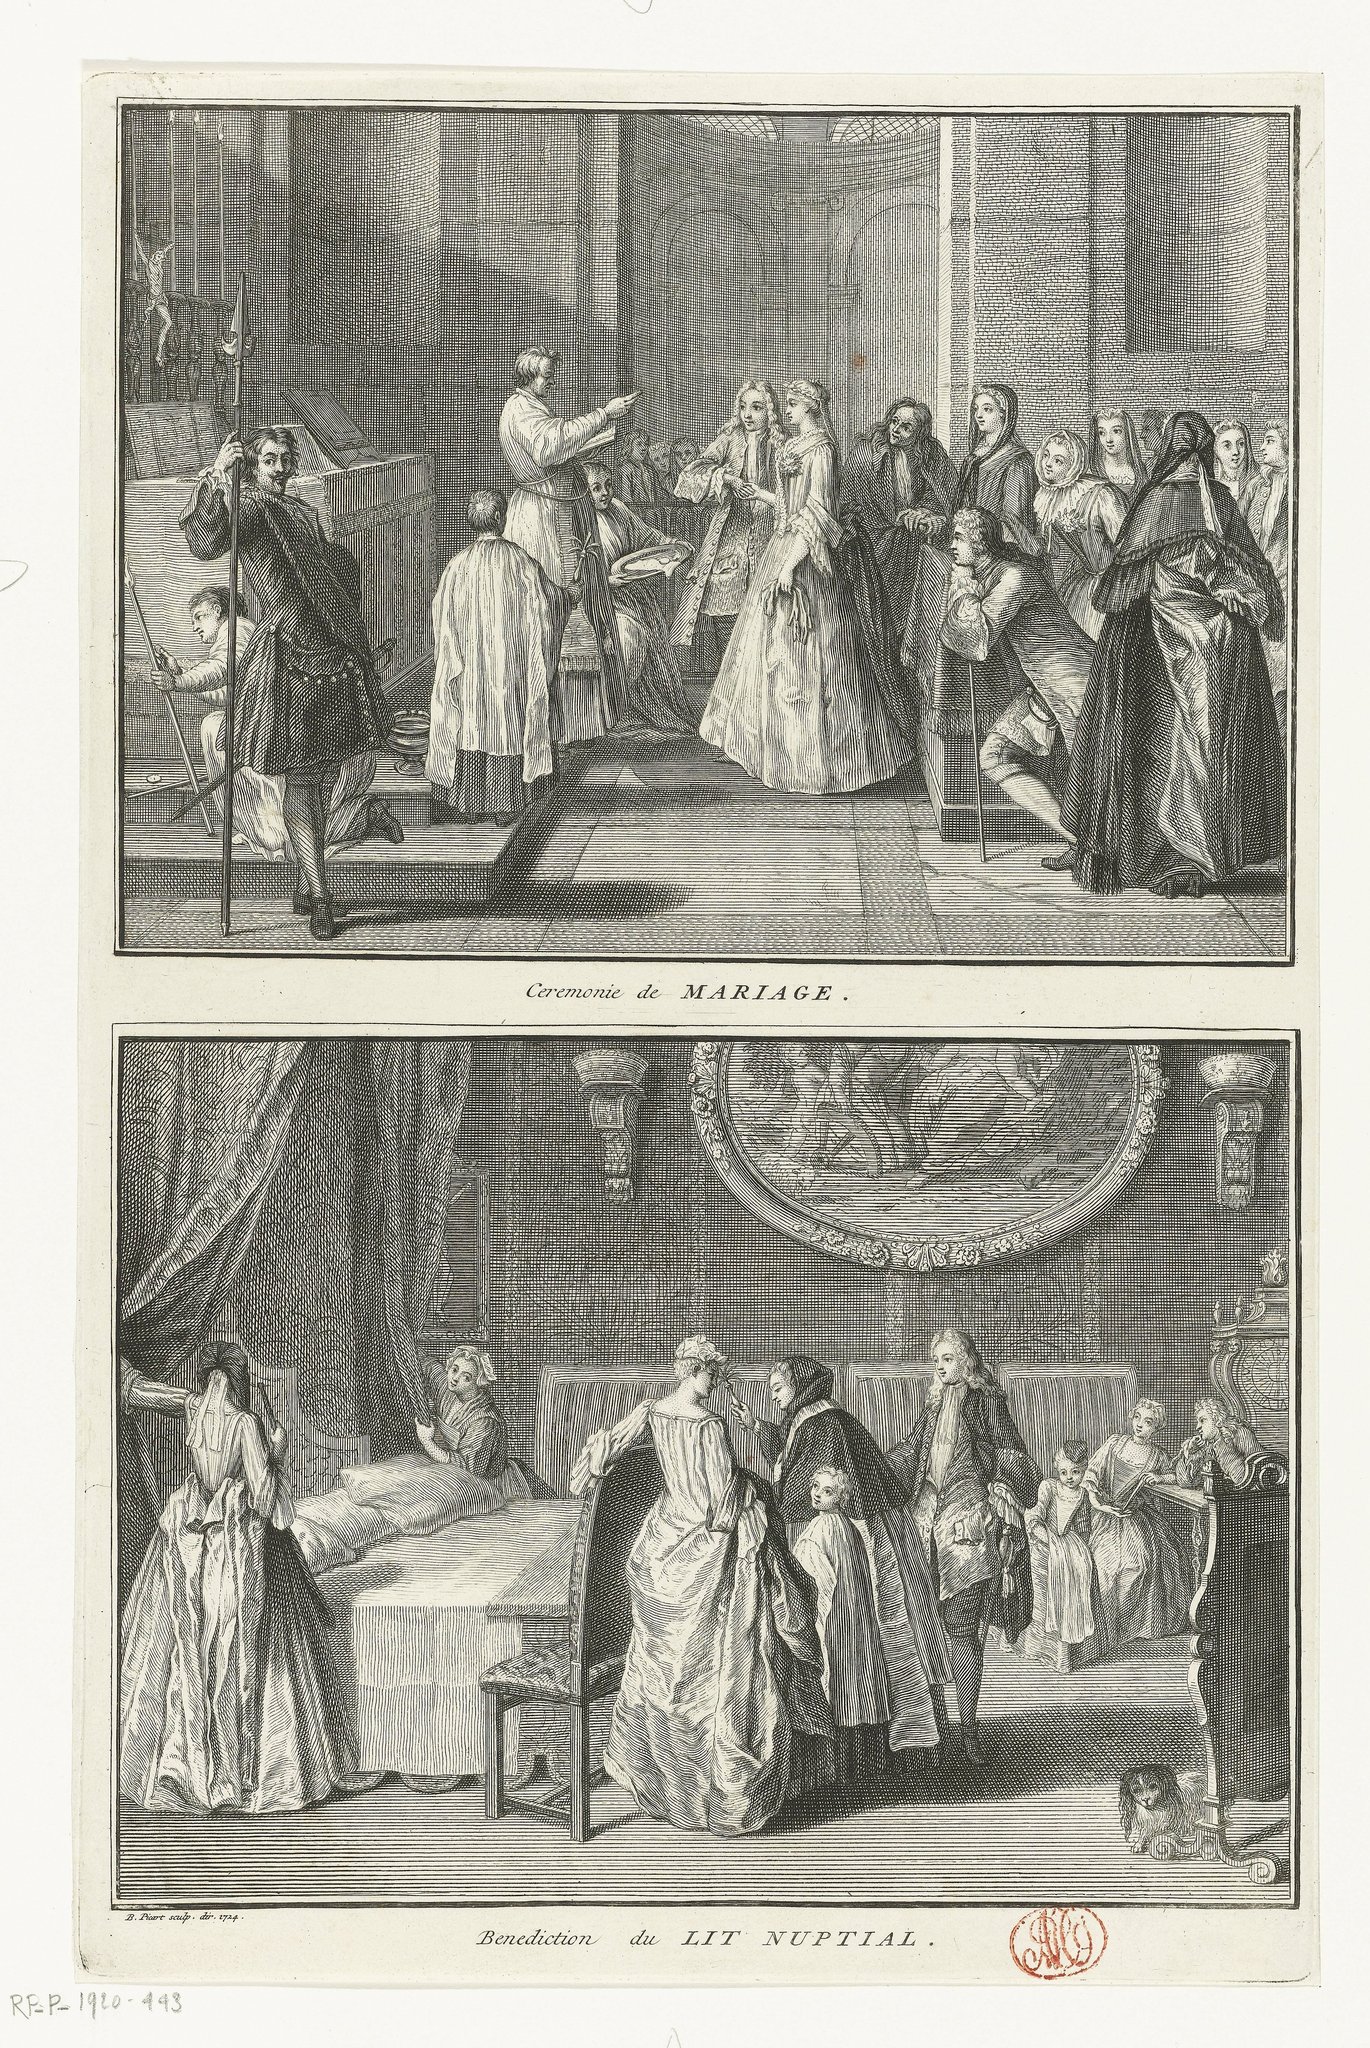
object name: print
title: Rooms-katholieke huwelijksplechtigheid en de zegening van het huwelijksbed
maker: bernard picart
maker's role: draughtsman, print maker, publisher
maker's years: 1673-1733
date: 1724-1727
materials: paper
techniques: engraving, etching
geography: amsterdam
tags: marriage in church ~ the sixth of the seven sacraments, clothes, costume (+ women's clothes), clothes, costume (+ men's clothes), blessing the married couple, (civil) marriage ceremonies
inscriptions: collector's mark: Lugt 2233, collector's mark: Lugt 195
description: Prent ook gebruikt in: Picart, Bernard. Ceremonies et coutumes religieuses de tous les peuples du monde (...). 10 delen. Amsterdam: Jean Frederic Bernard, 1723-1743, dl. 2 (1723), na p. 114. En in de Nederlandse vertaling: Picart, Bernard en Abraham Moubach. Naaukeurige beschryving der uitwendige godtsdienst-plichten, kerk-zeden en gewoontens van alle volkeren der waereldt : in een historisch verhaal (...). 6 delen. 's-Gravenhage: Rutgert Christoffel Alberts, 1727-1738, dl. 2 (1727), na p. 106. En waarschijnlijk ook in de Engelse vertaling.